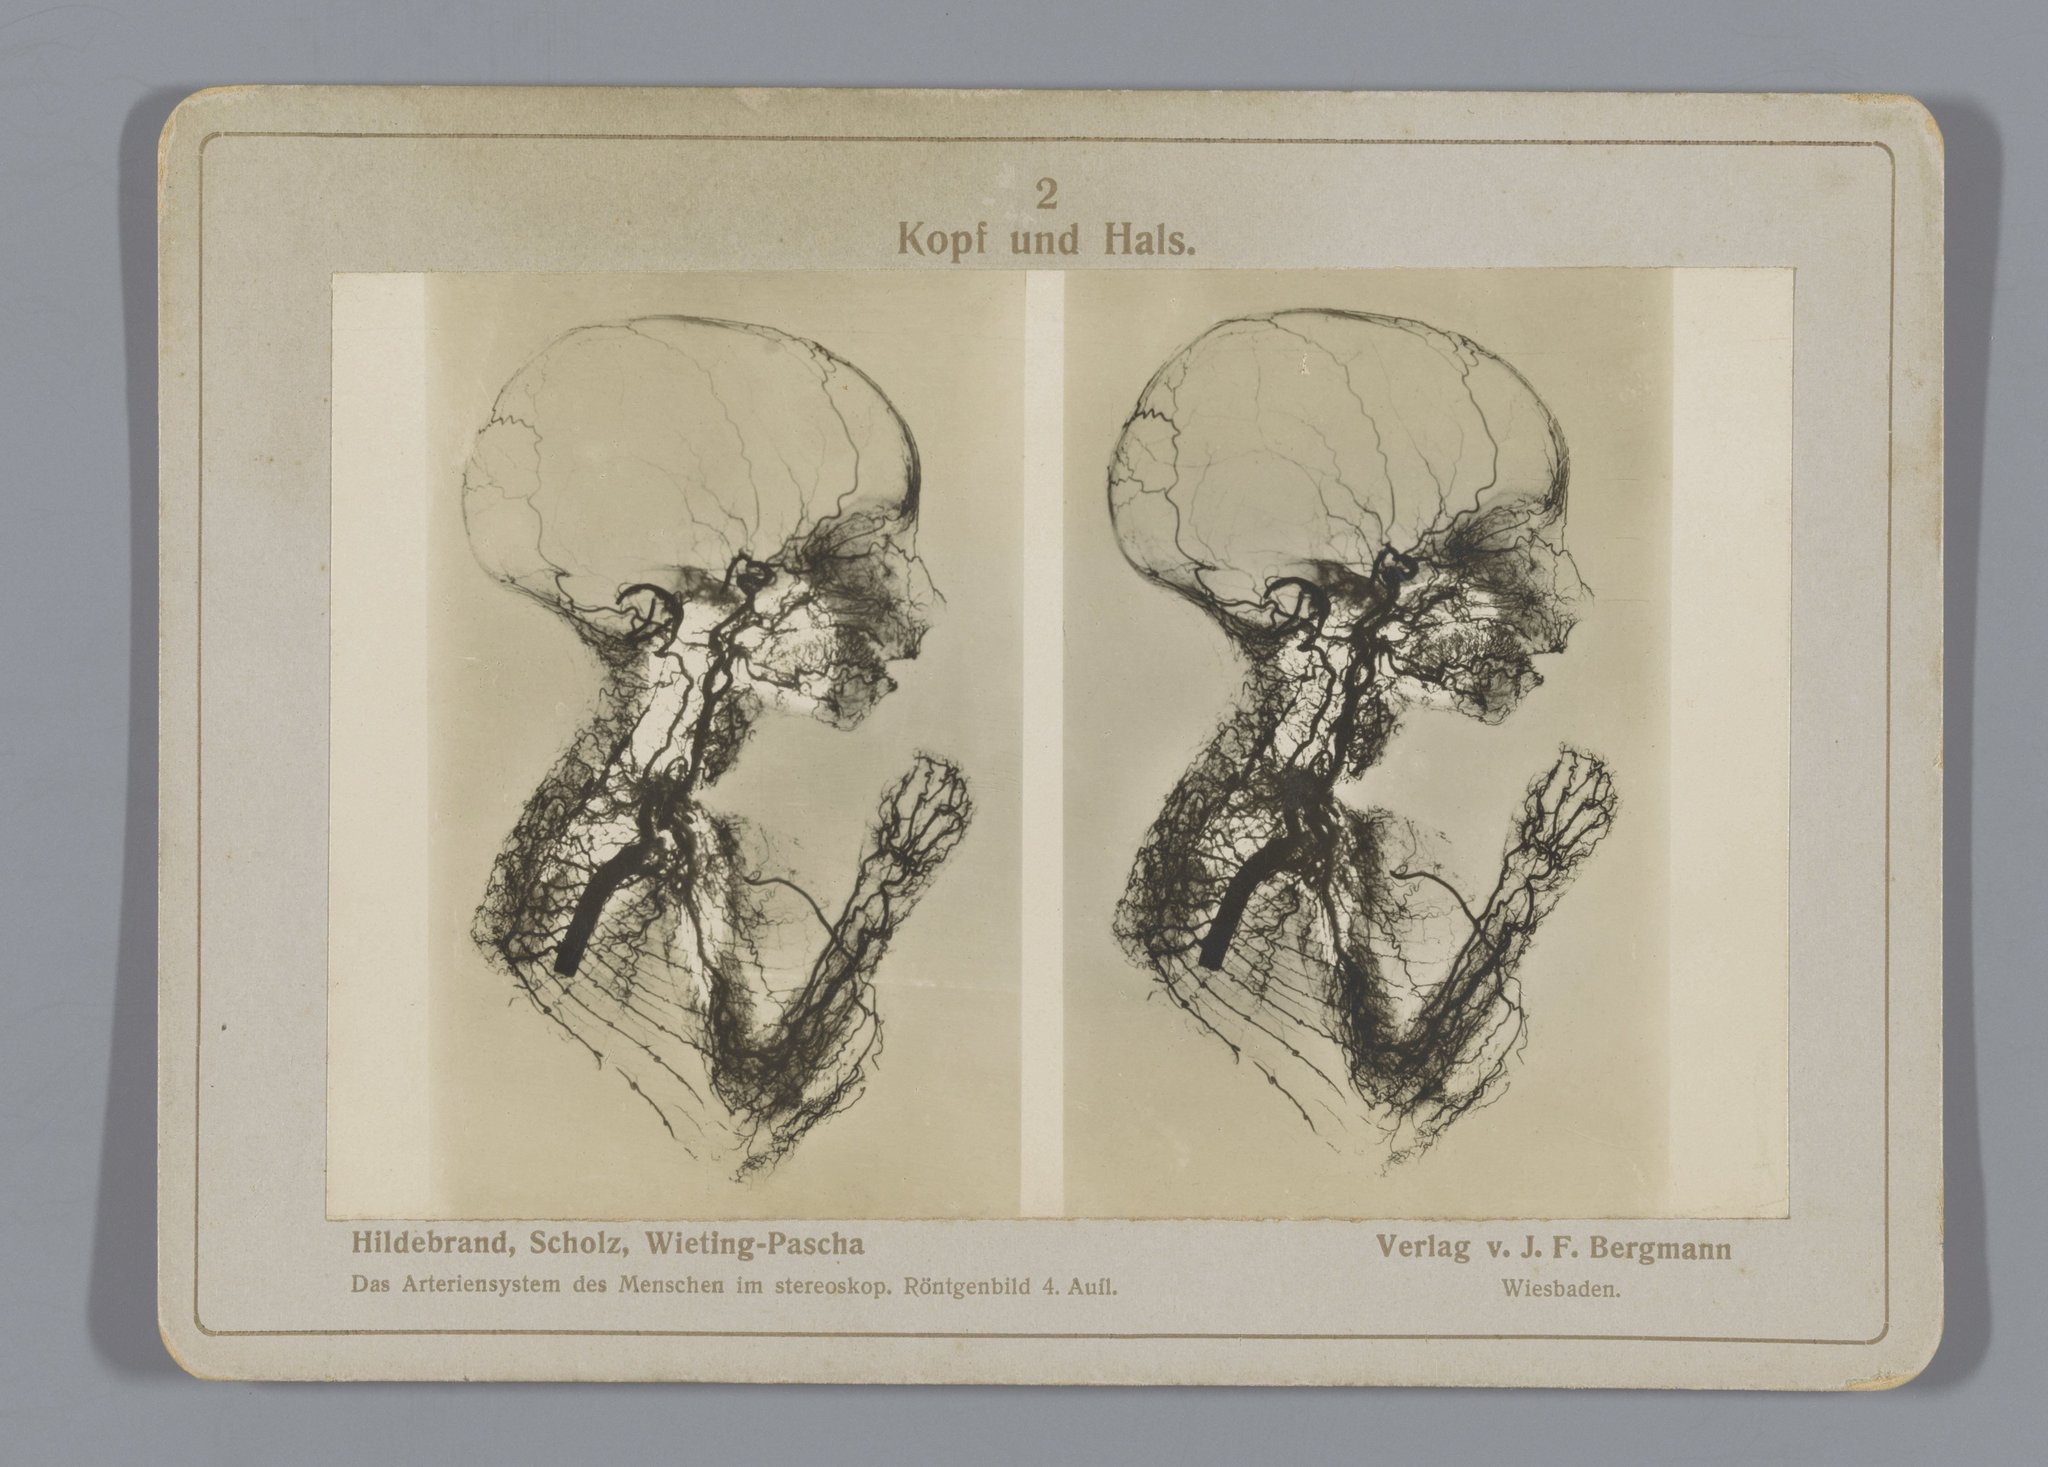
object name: stereograph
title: Das Arteriensystem des Menschen im stereoskop. Röntgenbild 4. Auflage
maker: joseph friedrich bergmann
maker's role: publisher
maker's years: 1849-1917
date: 1917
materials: paper, cardboard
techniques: gelatin silver print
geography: wiesbaden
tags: arteries, physiology and anatomy ~ circulatory system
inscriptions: number: ‘2’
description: Foto afkomstig uit: Hildebrand, O., W. Scholz en J. Wieting. Das Arteriensystem des Menschen im stereoskopischen Röntgenbild, Sammlung von stereoskopischen Röntgenbildern aus dem Neuen Allgemeinen Krankenhaus Hamburg-Eppendorf. 4de druk. Wiesbaden: J.F. Bergmann, 1917.